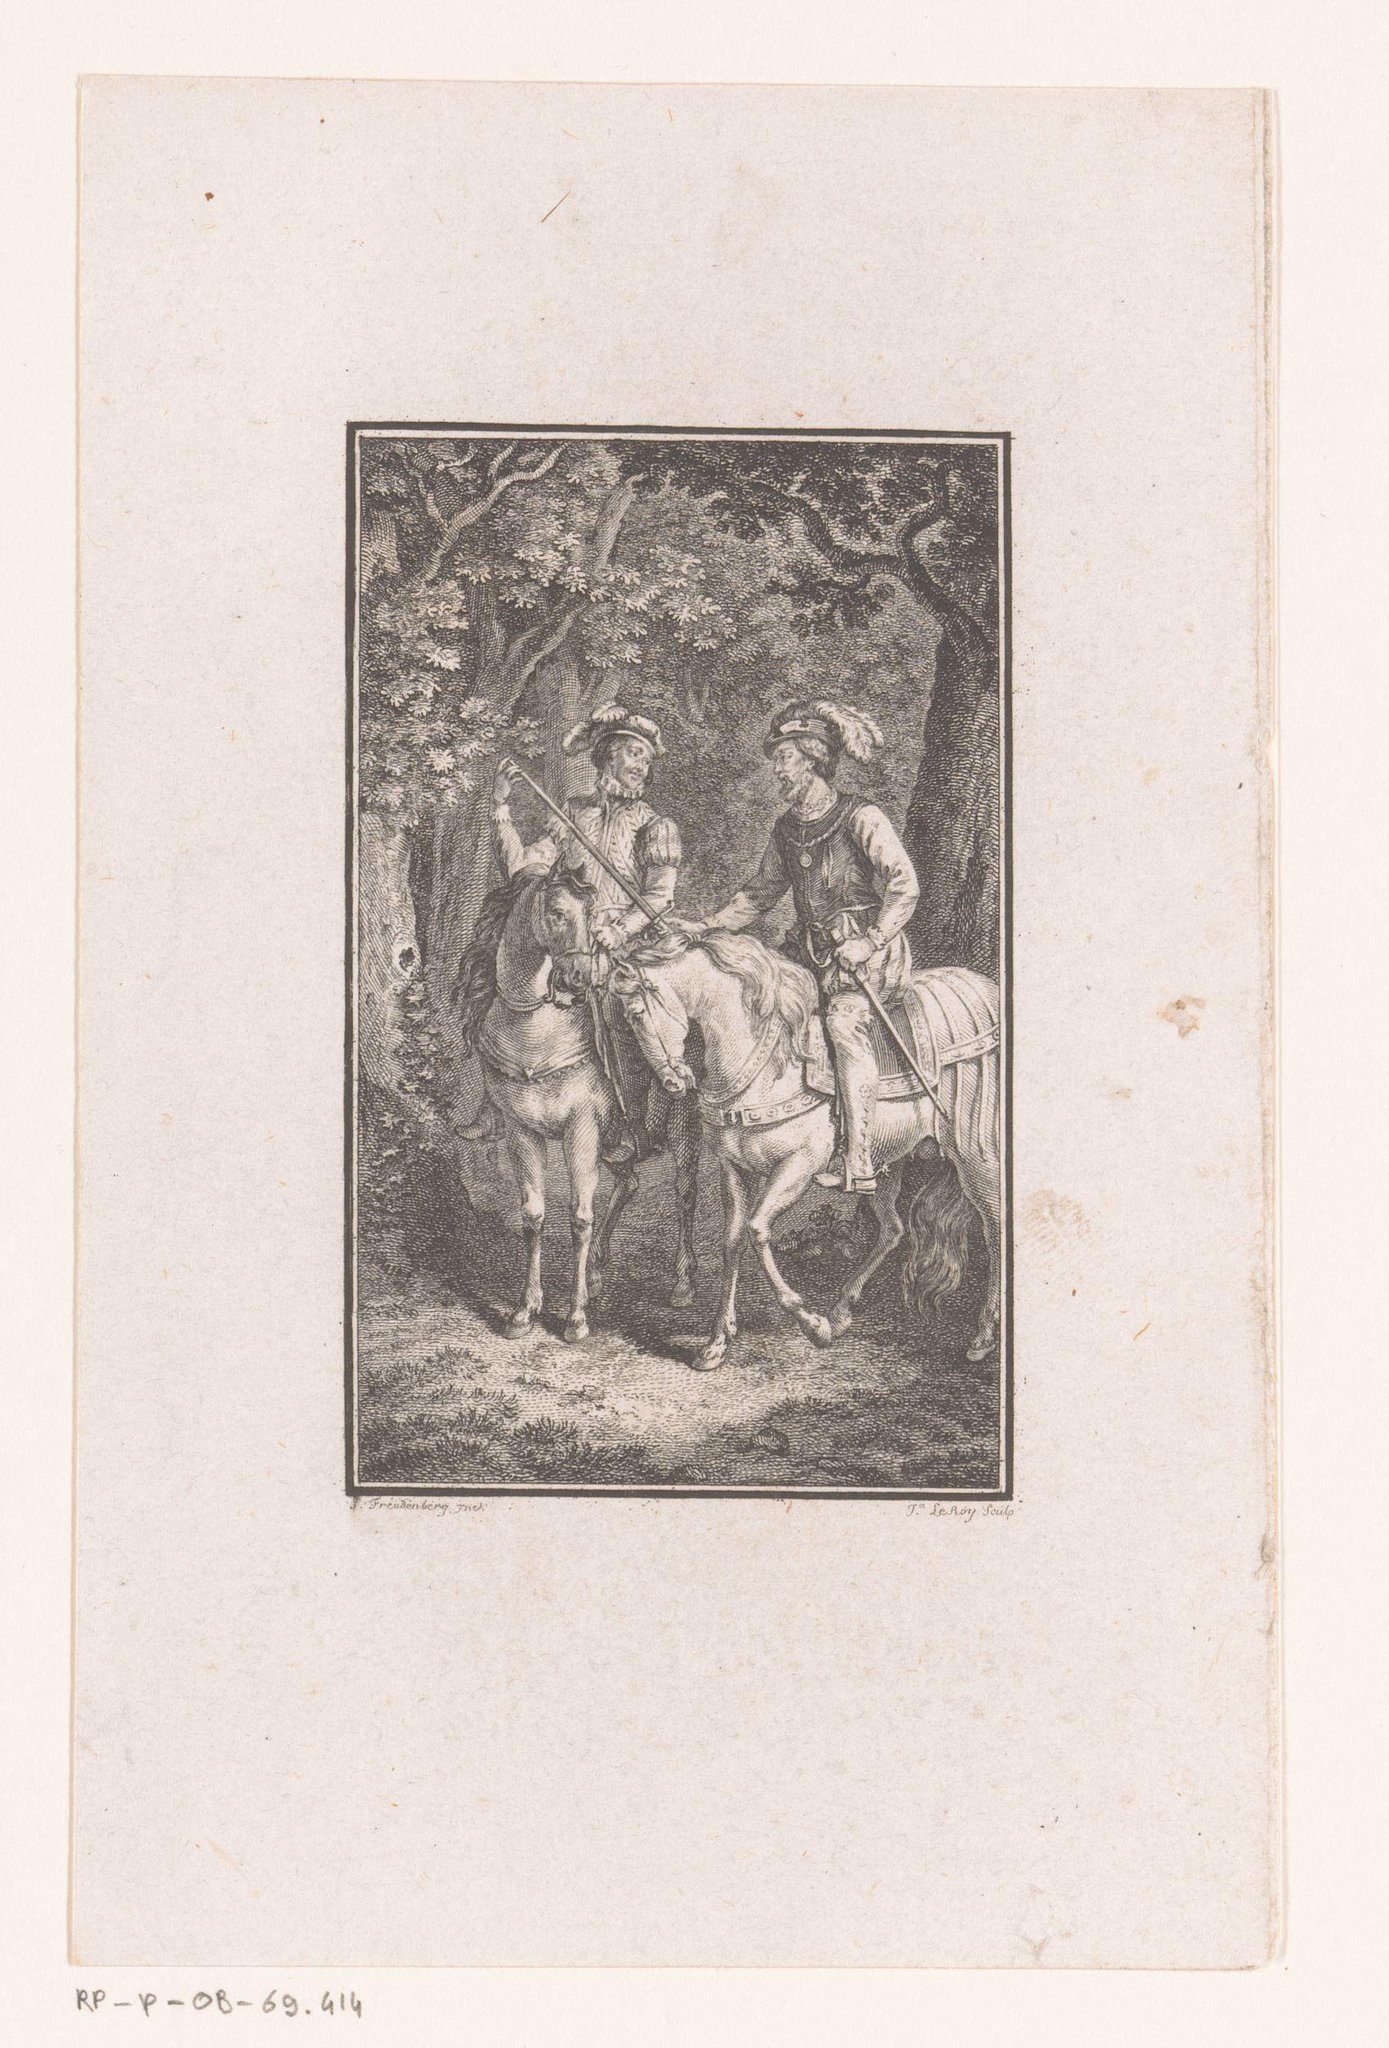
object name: print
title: Twee ruiters in bos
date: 1749-1799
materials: paper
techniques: etching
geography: bern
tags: riding a horse, ass, or mule; rider, horseman, forest fire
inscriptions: collector's mark: Lugt 2228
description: Mogelijk prent uit: Les Nouvelles de Marguerite, reine de Navarre. Bern: la nouvelle Société Typographique, 1780-1781.